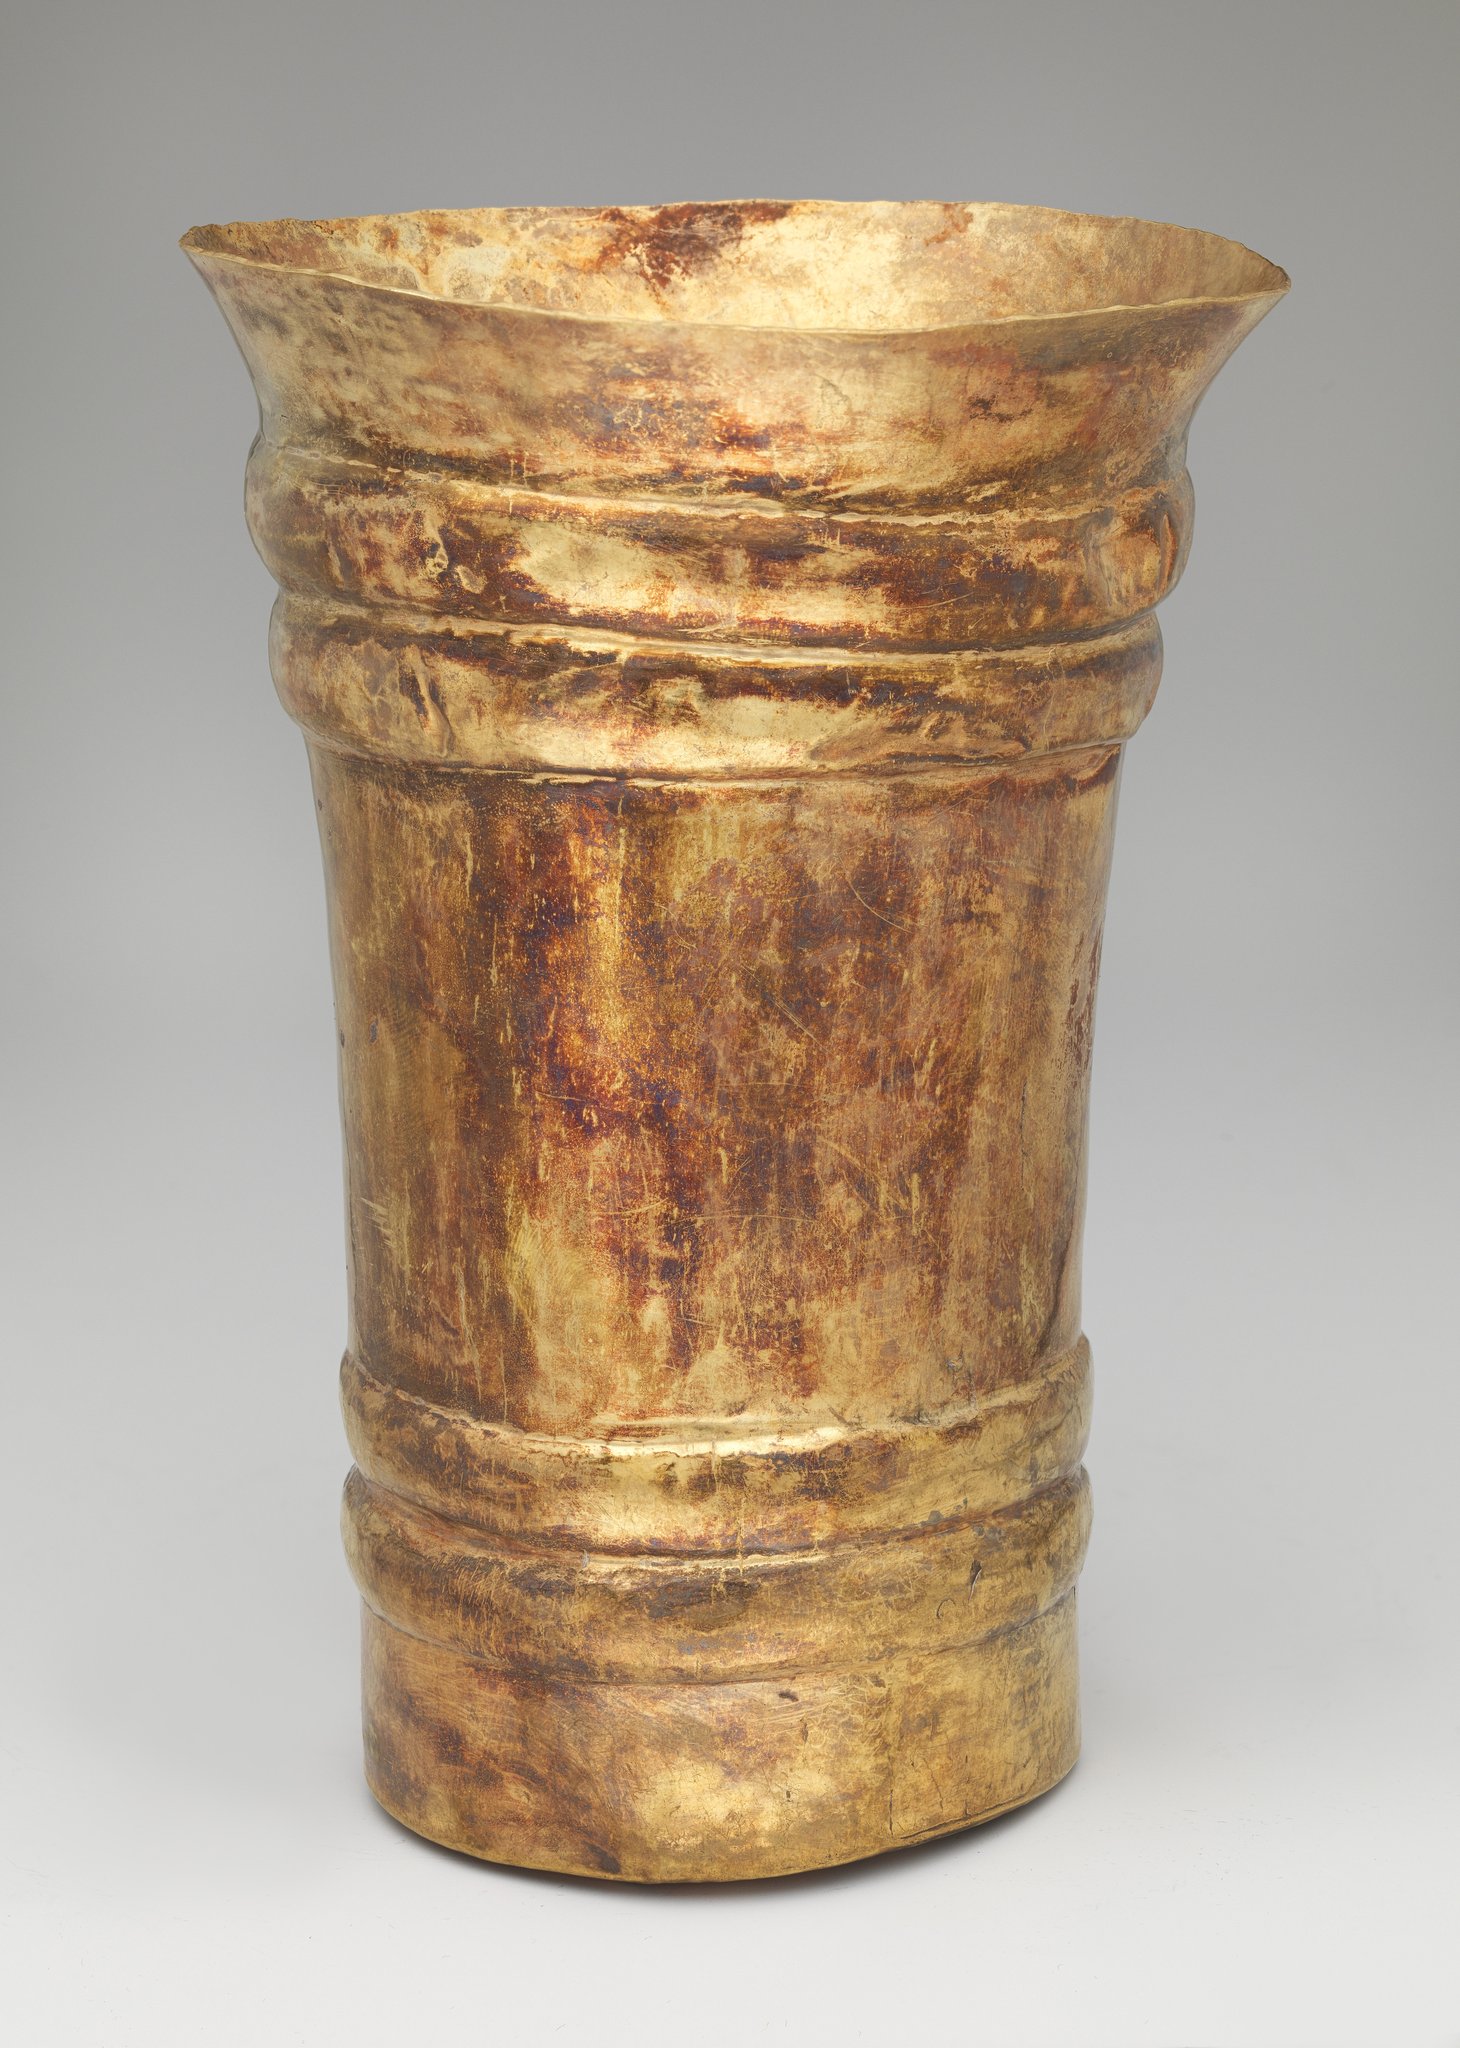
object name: beaker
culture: lambayeque, sicán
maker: lambayeque (sicán) artist(s)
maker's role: artist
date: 900-1100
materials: gold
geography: peru